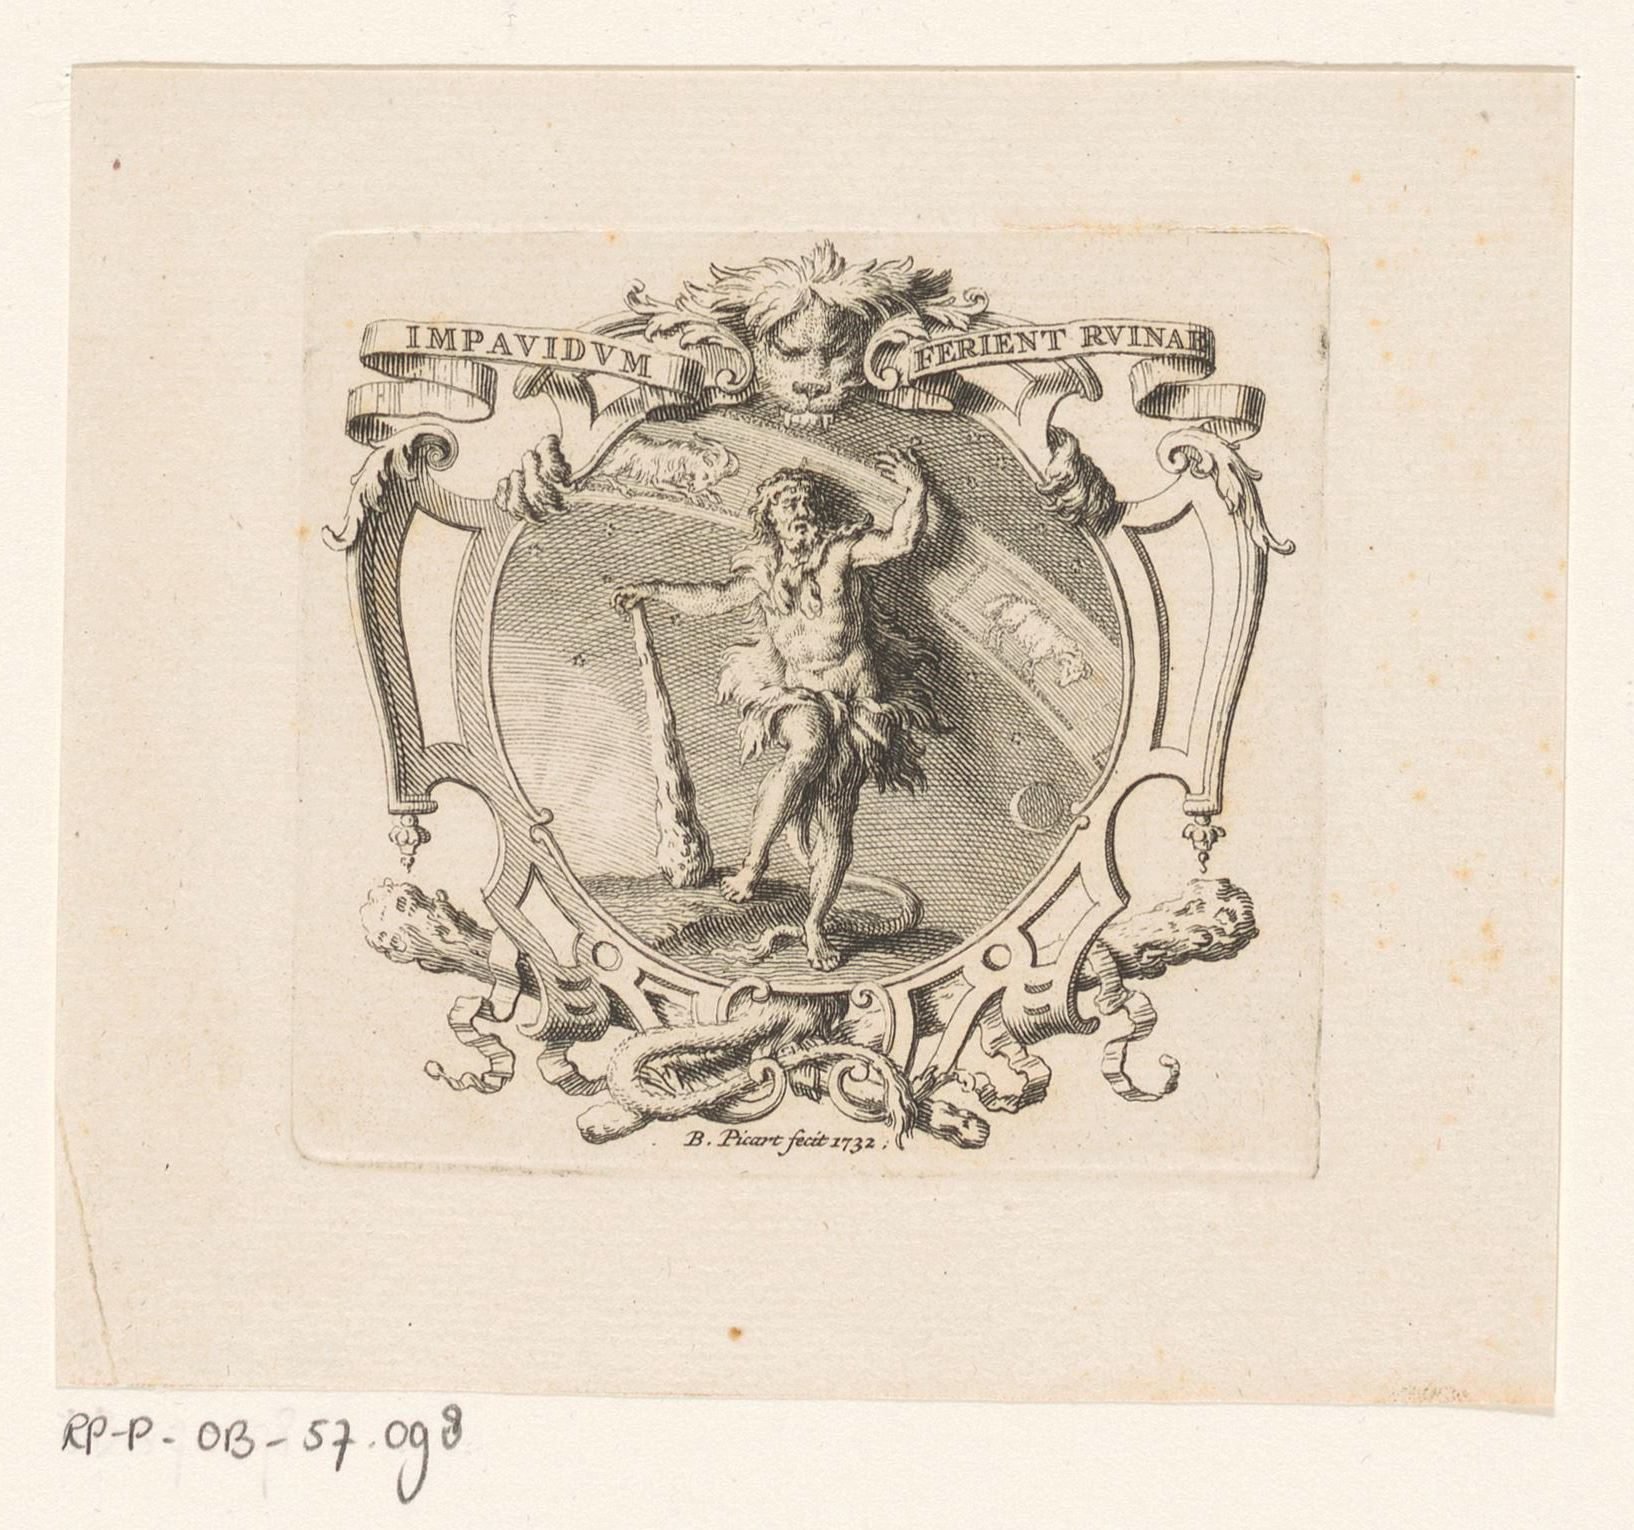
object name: print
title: Hercules met de zodiak op de achtergrond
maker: bernard picart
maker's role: draughtsman, print maker, publisher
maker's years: 1673-1733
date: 1732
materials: paper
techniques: engraving, etching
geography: amsterdam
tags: (story of) hercules (heracles), taurus (zodiacal sign of april), aries (zodical sign of march)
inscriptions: collector's mark: Lugt 2228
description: Hercules met de knots in zijn hand. Op de achtergrond een deel van de zodiak met stier en ram. Boven de voorstelling het devies: Impavidum Ferient Ruinae. Rond de voorstelling een ornamentele lijst met de attributen van Hercules.